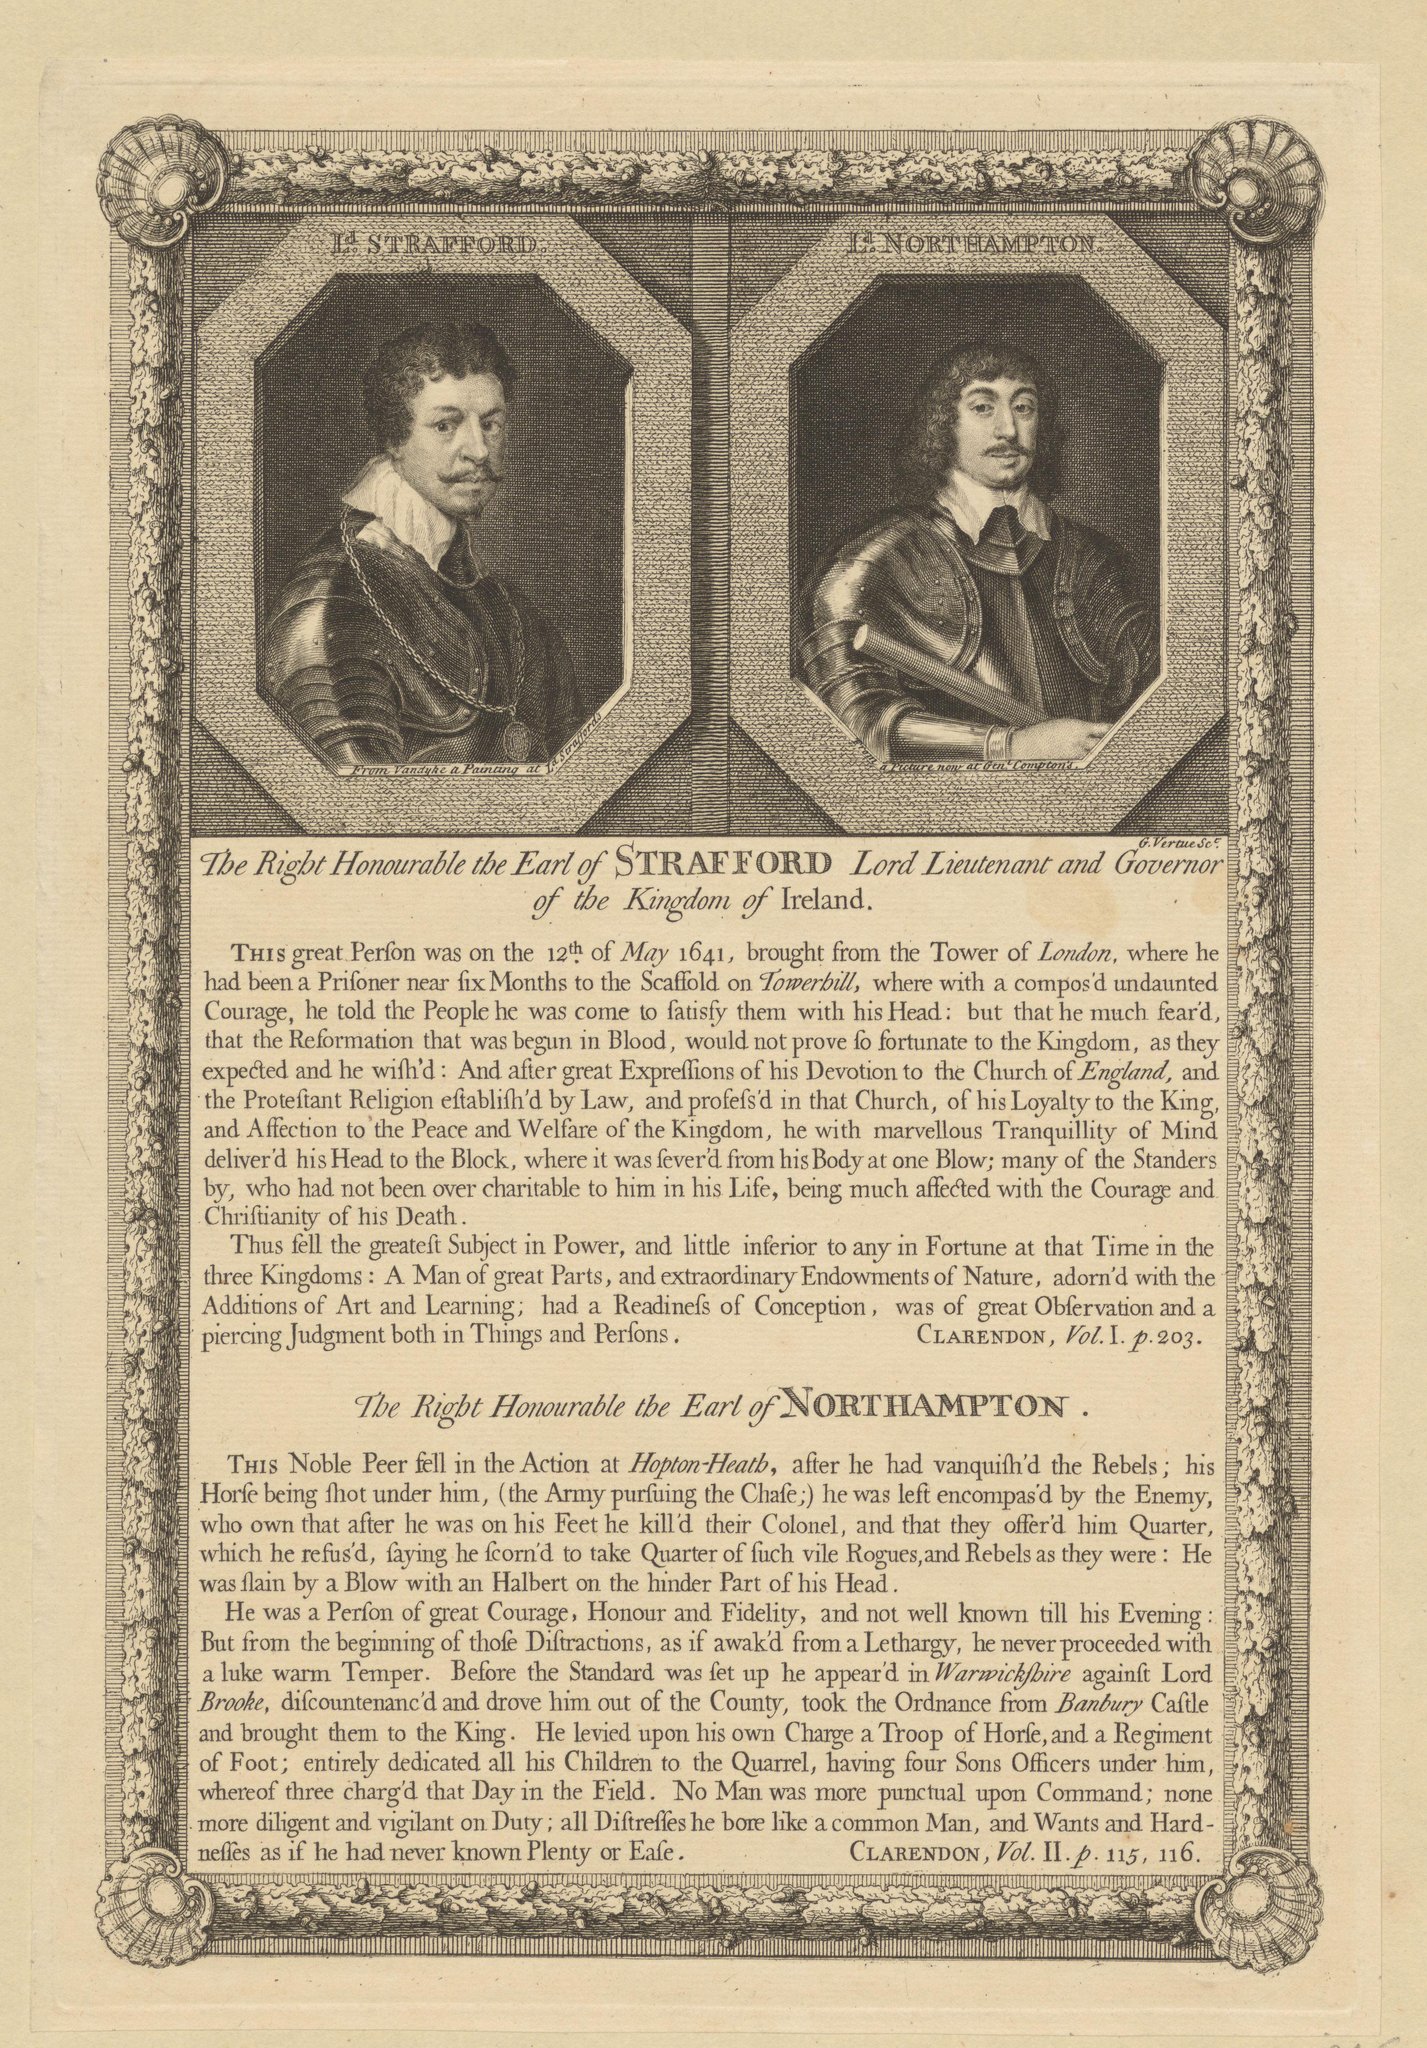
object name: print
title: Portret van Thomas Wentworth, 1e graaf van Strafford, en Spencer Compton, 2e graaf van Northampton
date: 1795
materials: paper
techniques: engraving, etching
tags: london, politician, historical persons, politician, e.g. party leader, officer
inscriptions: collector's mark: Lugt 240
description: Subsecties van tekst en prent mogelijk gebruikt in: Clarendon, Edward Hyde. Memoirs of King Charles I. and the Loyalists who Suffered in Their Cause (...). Londen: Isaac Herbert, 1795.